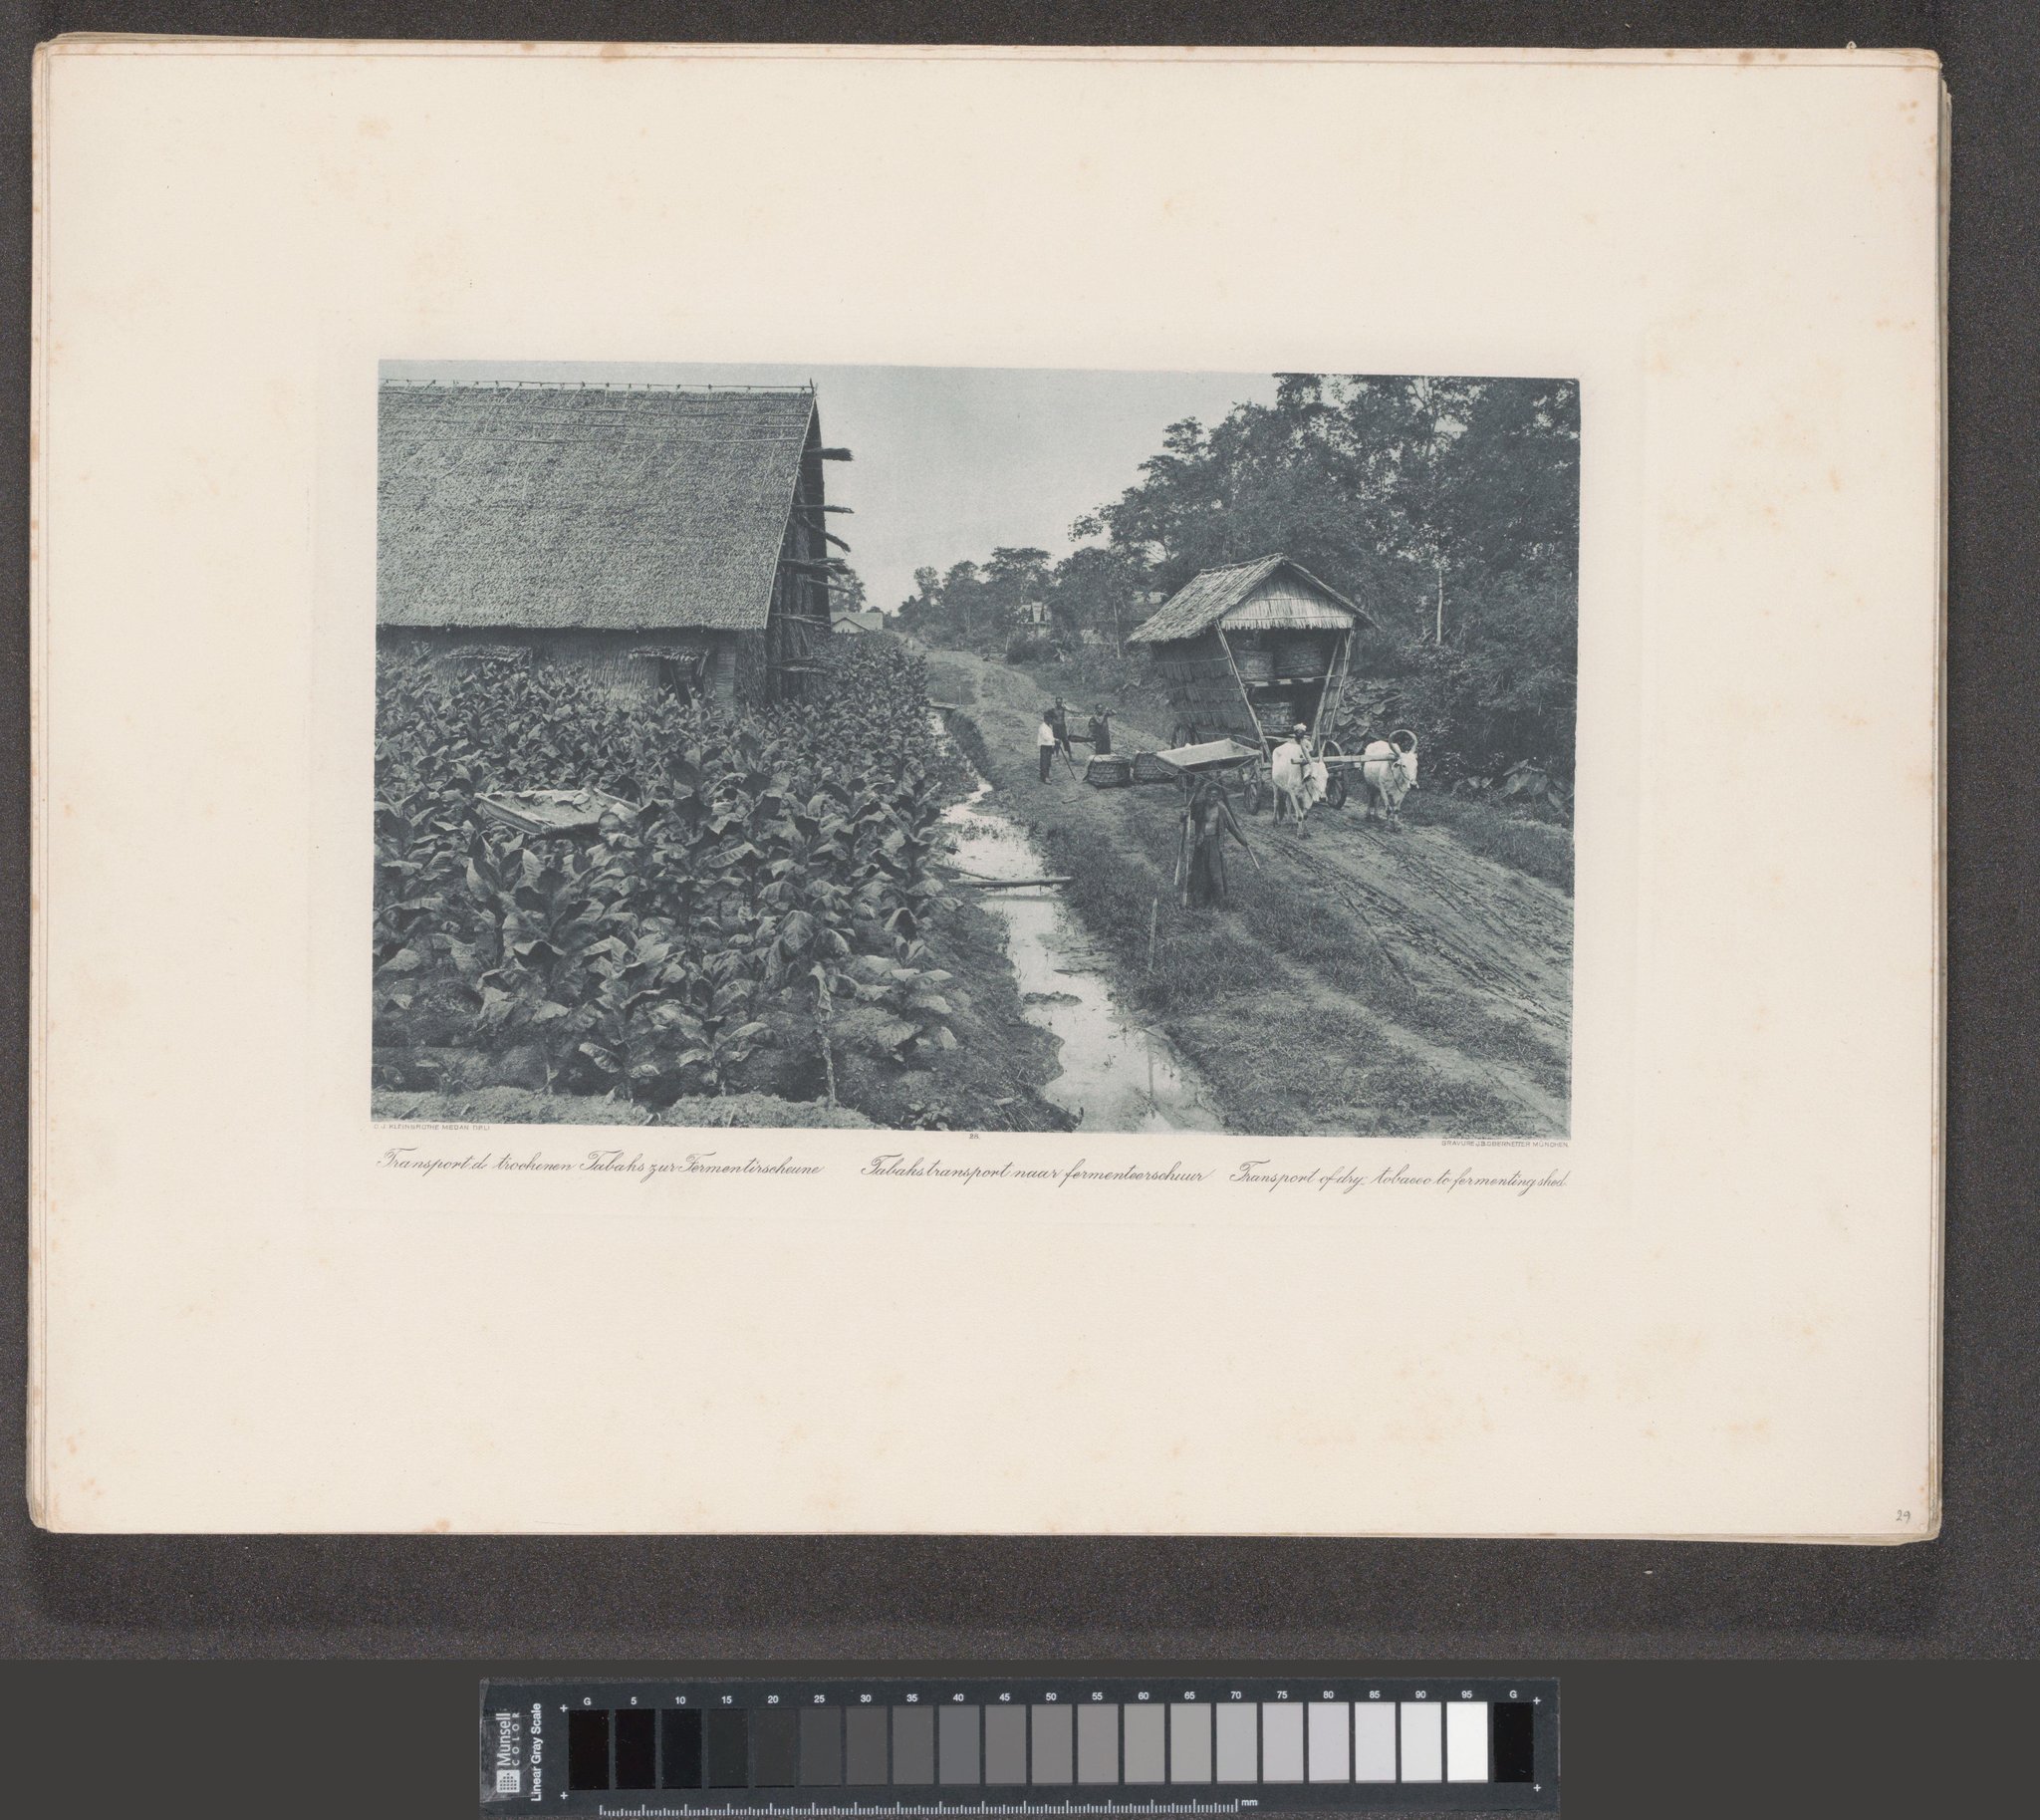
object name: photomechanical print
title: Transport van tabak per ossenkar naar een fermenteerschuur van een plantage op Sumatra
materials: paper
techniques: photoaquatint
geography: sumatra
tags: plantation, field filled with a crop, two-wheeled, animal-drawn vehicle, tobacco, sumatra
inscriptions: number: ‘28’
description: Onderdeel van Album met heliogravures van Sumatra's oostkust.